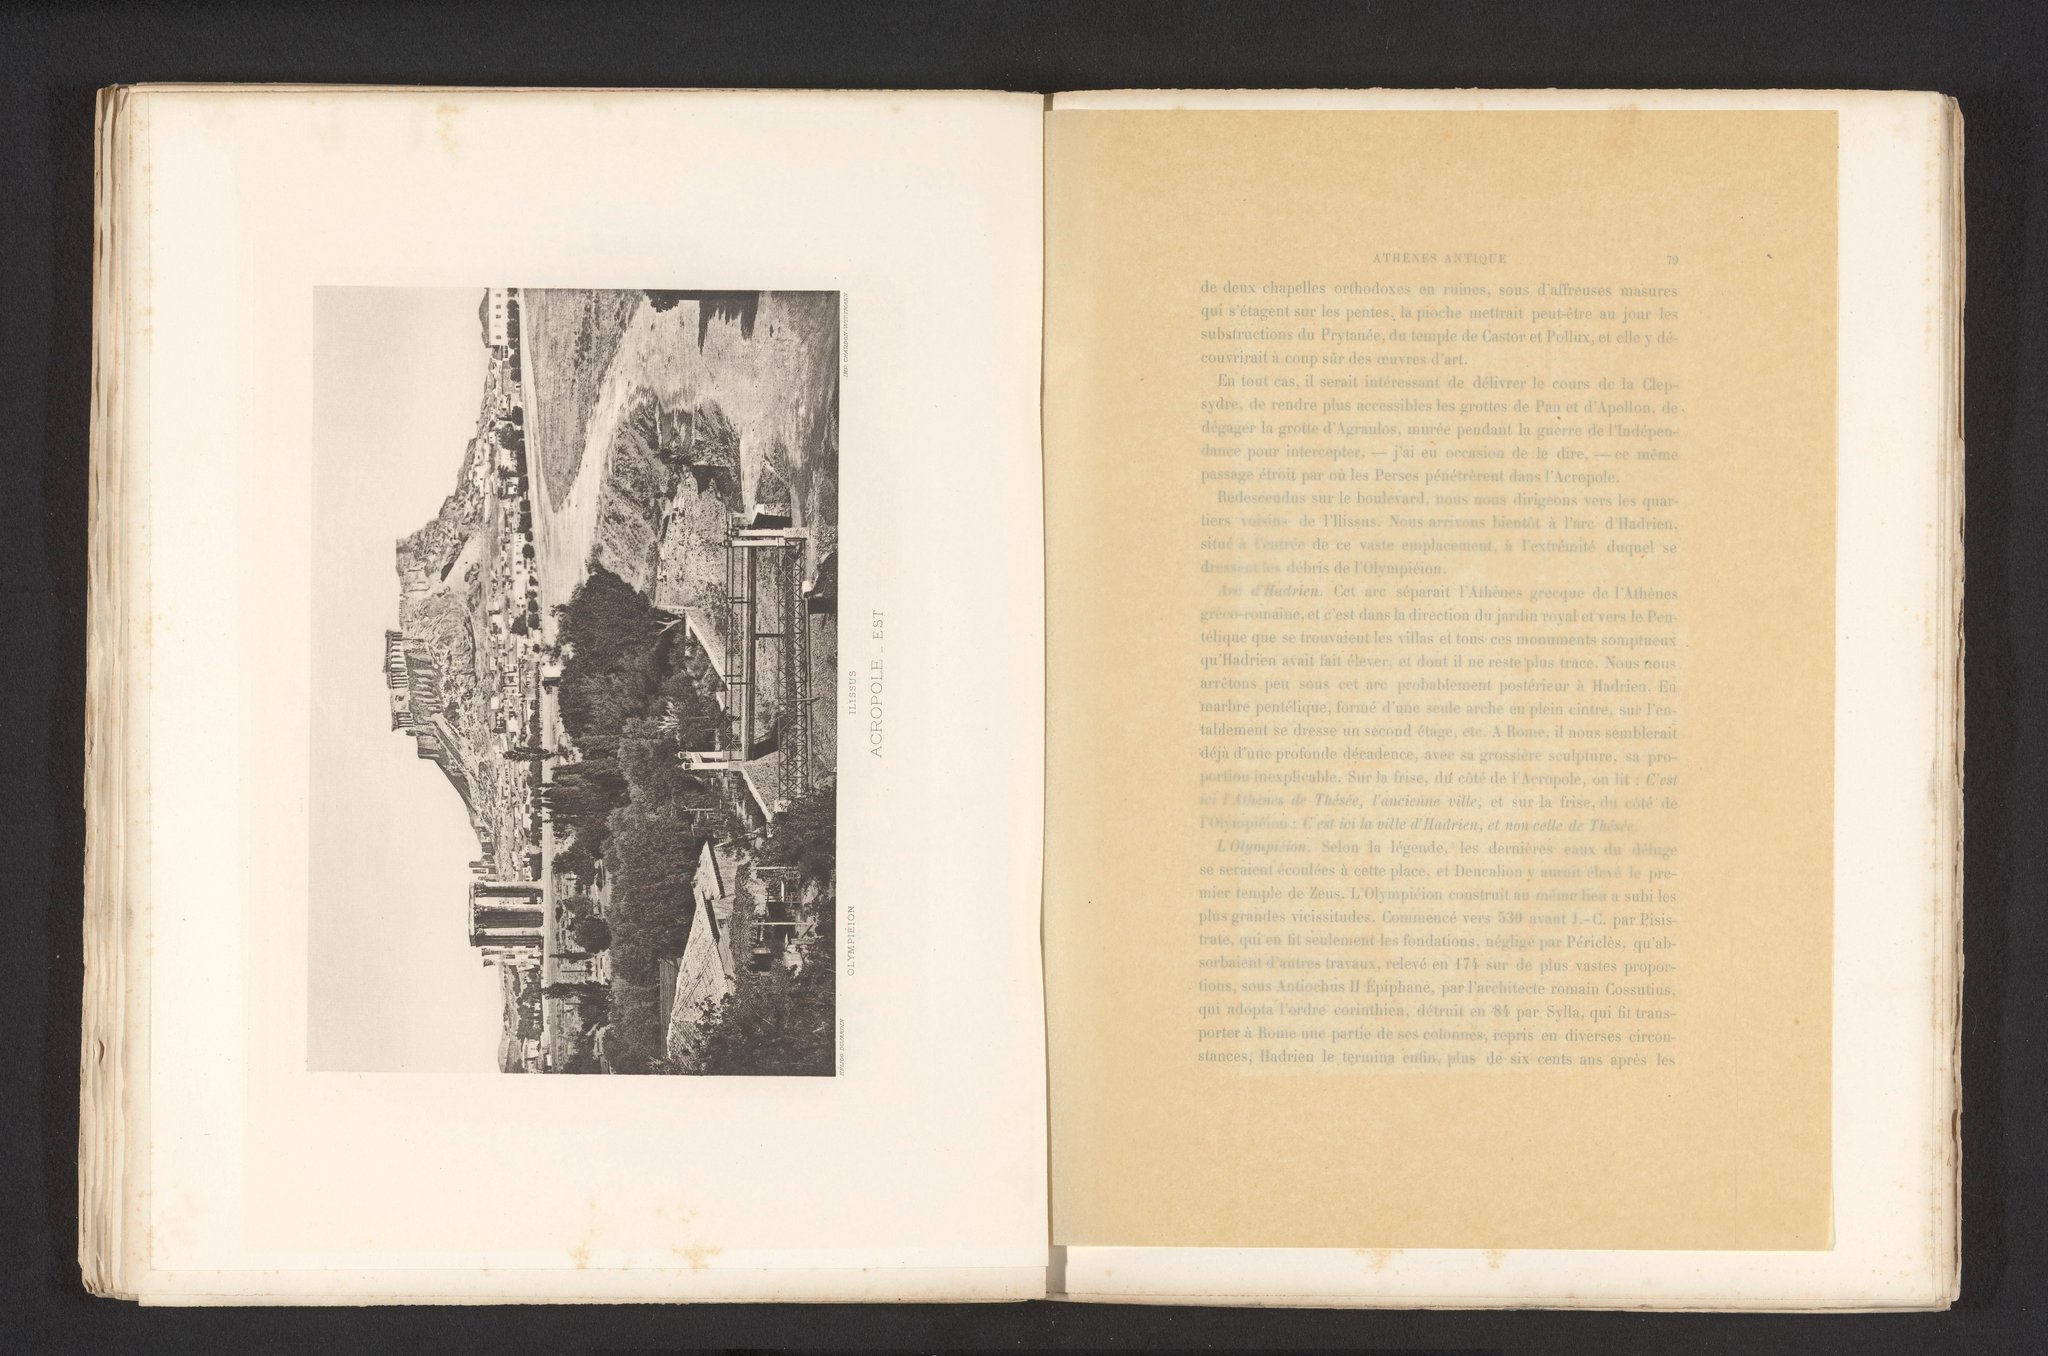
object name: photomechanical print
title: Acropole-est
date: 1880-1890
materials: paper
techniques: photoaquatint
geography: athens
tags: city-view in general; 'veduta', ruin of a building ~ architecture